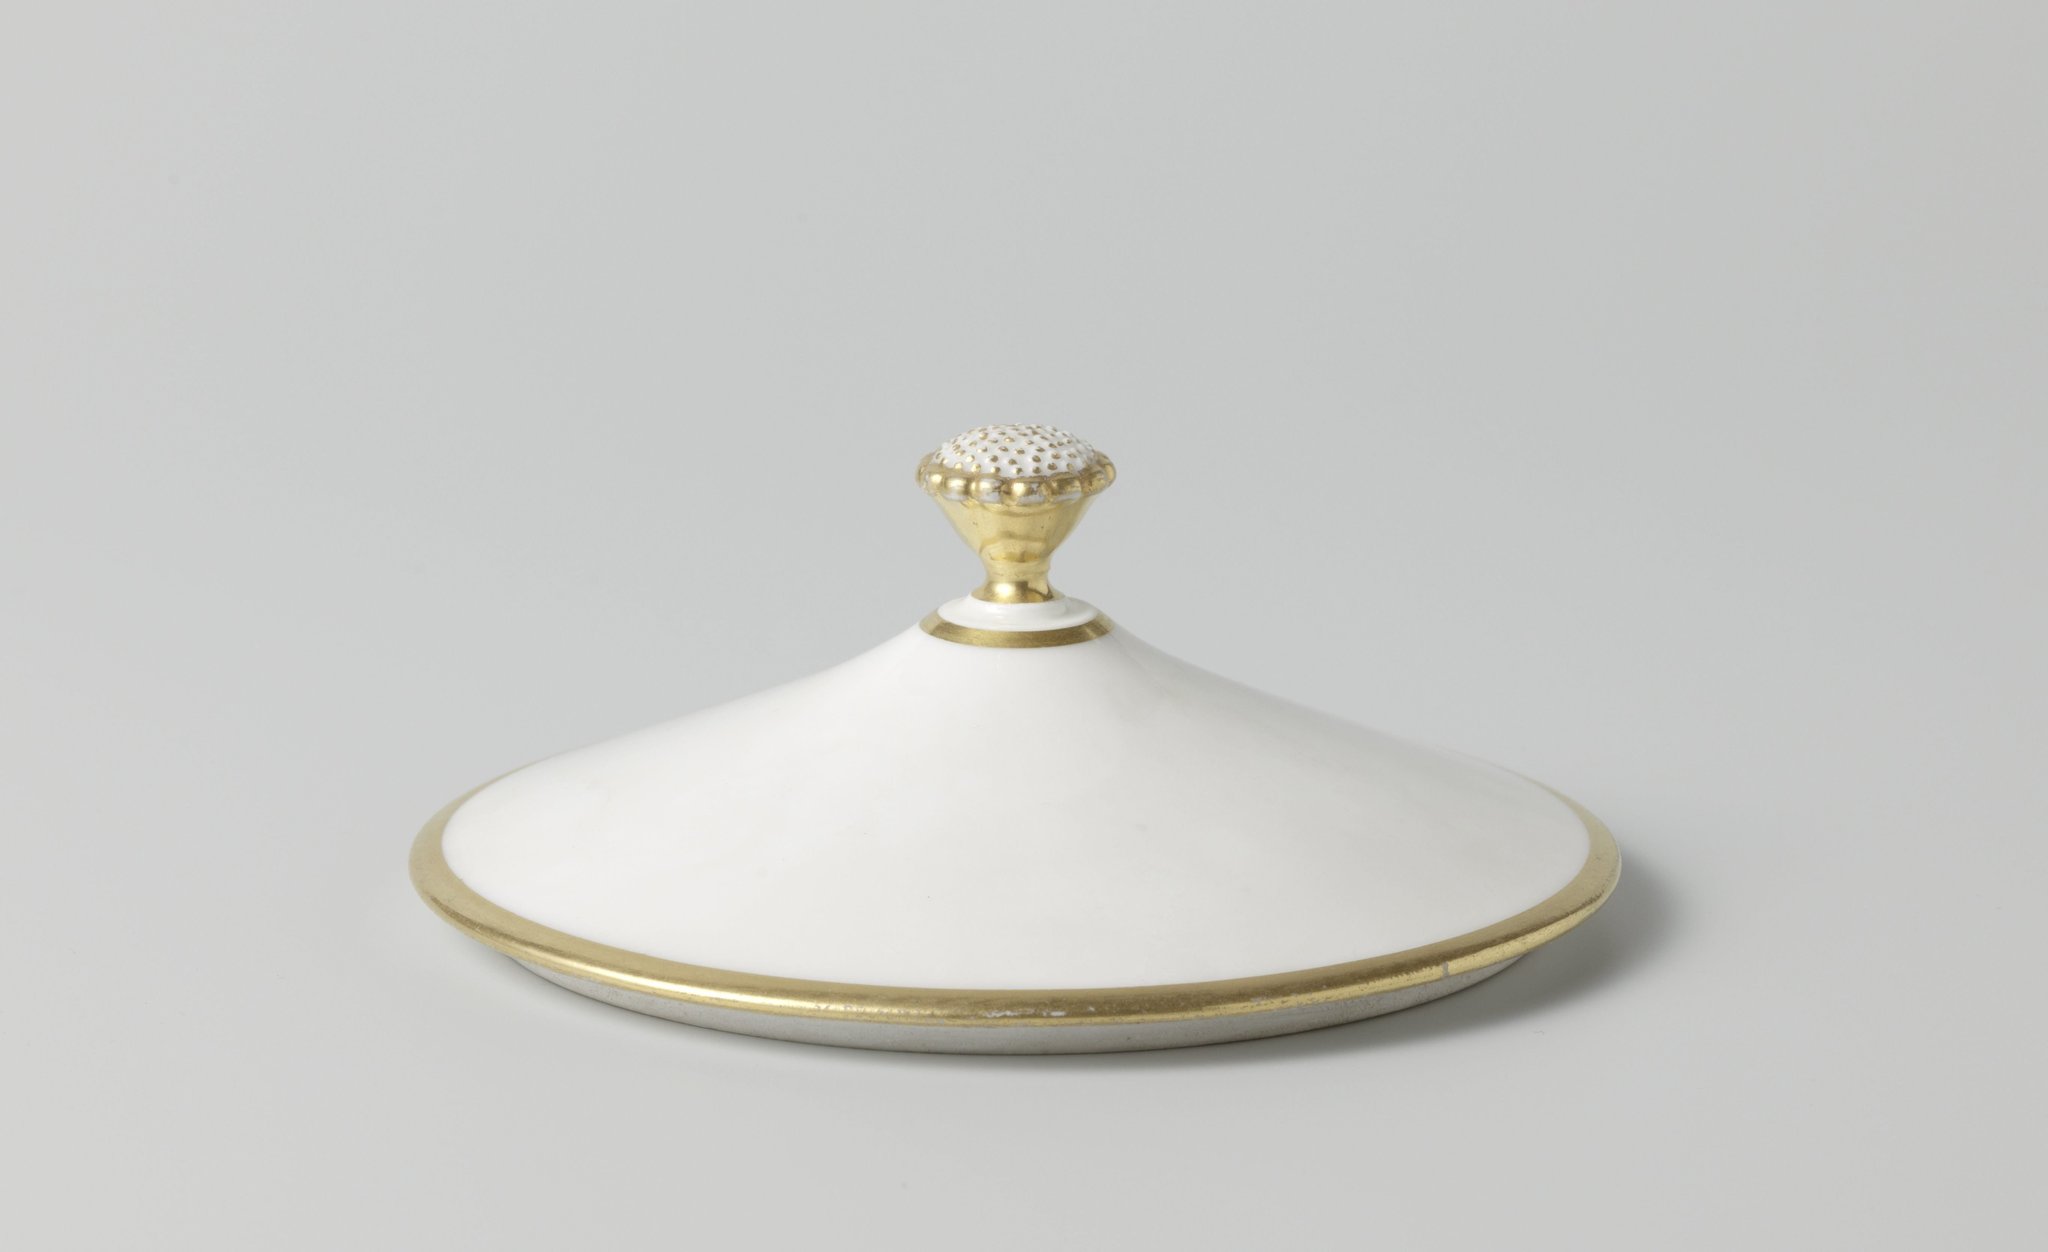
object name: lid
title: Cover of a tureen with golden borders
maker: Anonymous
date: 1800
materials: glaze, gold, paint, porcelain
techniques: firing, forming, gilding, turning, vitrification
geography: france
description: Deksel van porselein, behorend bij een schaal (A), versierd met gouden banden en met vrouwenkopjes aan de hoog opgaande oren. Schaal gemerkt: Co 61.